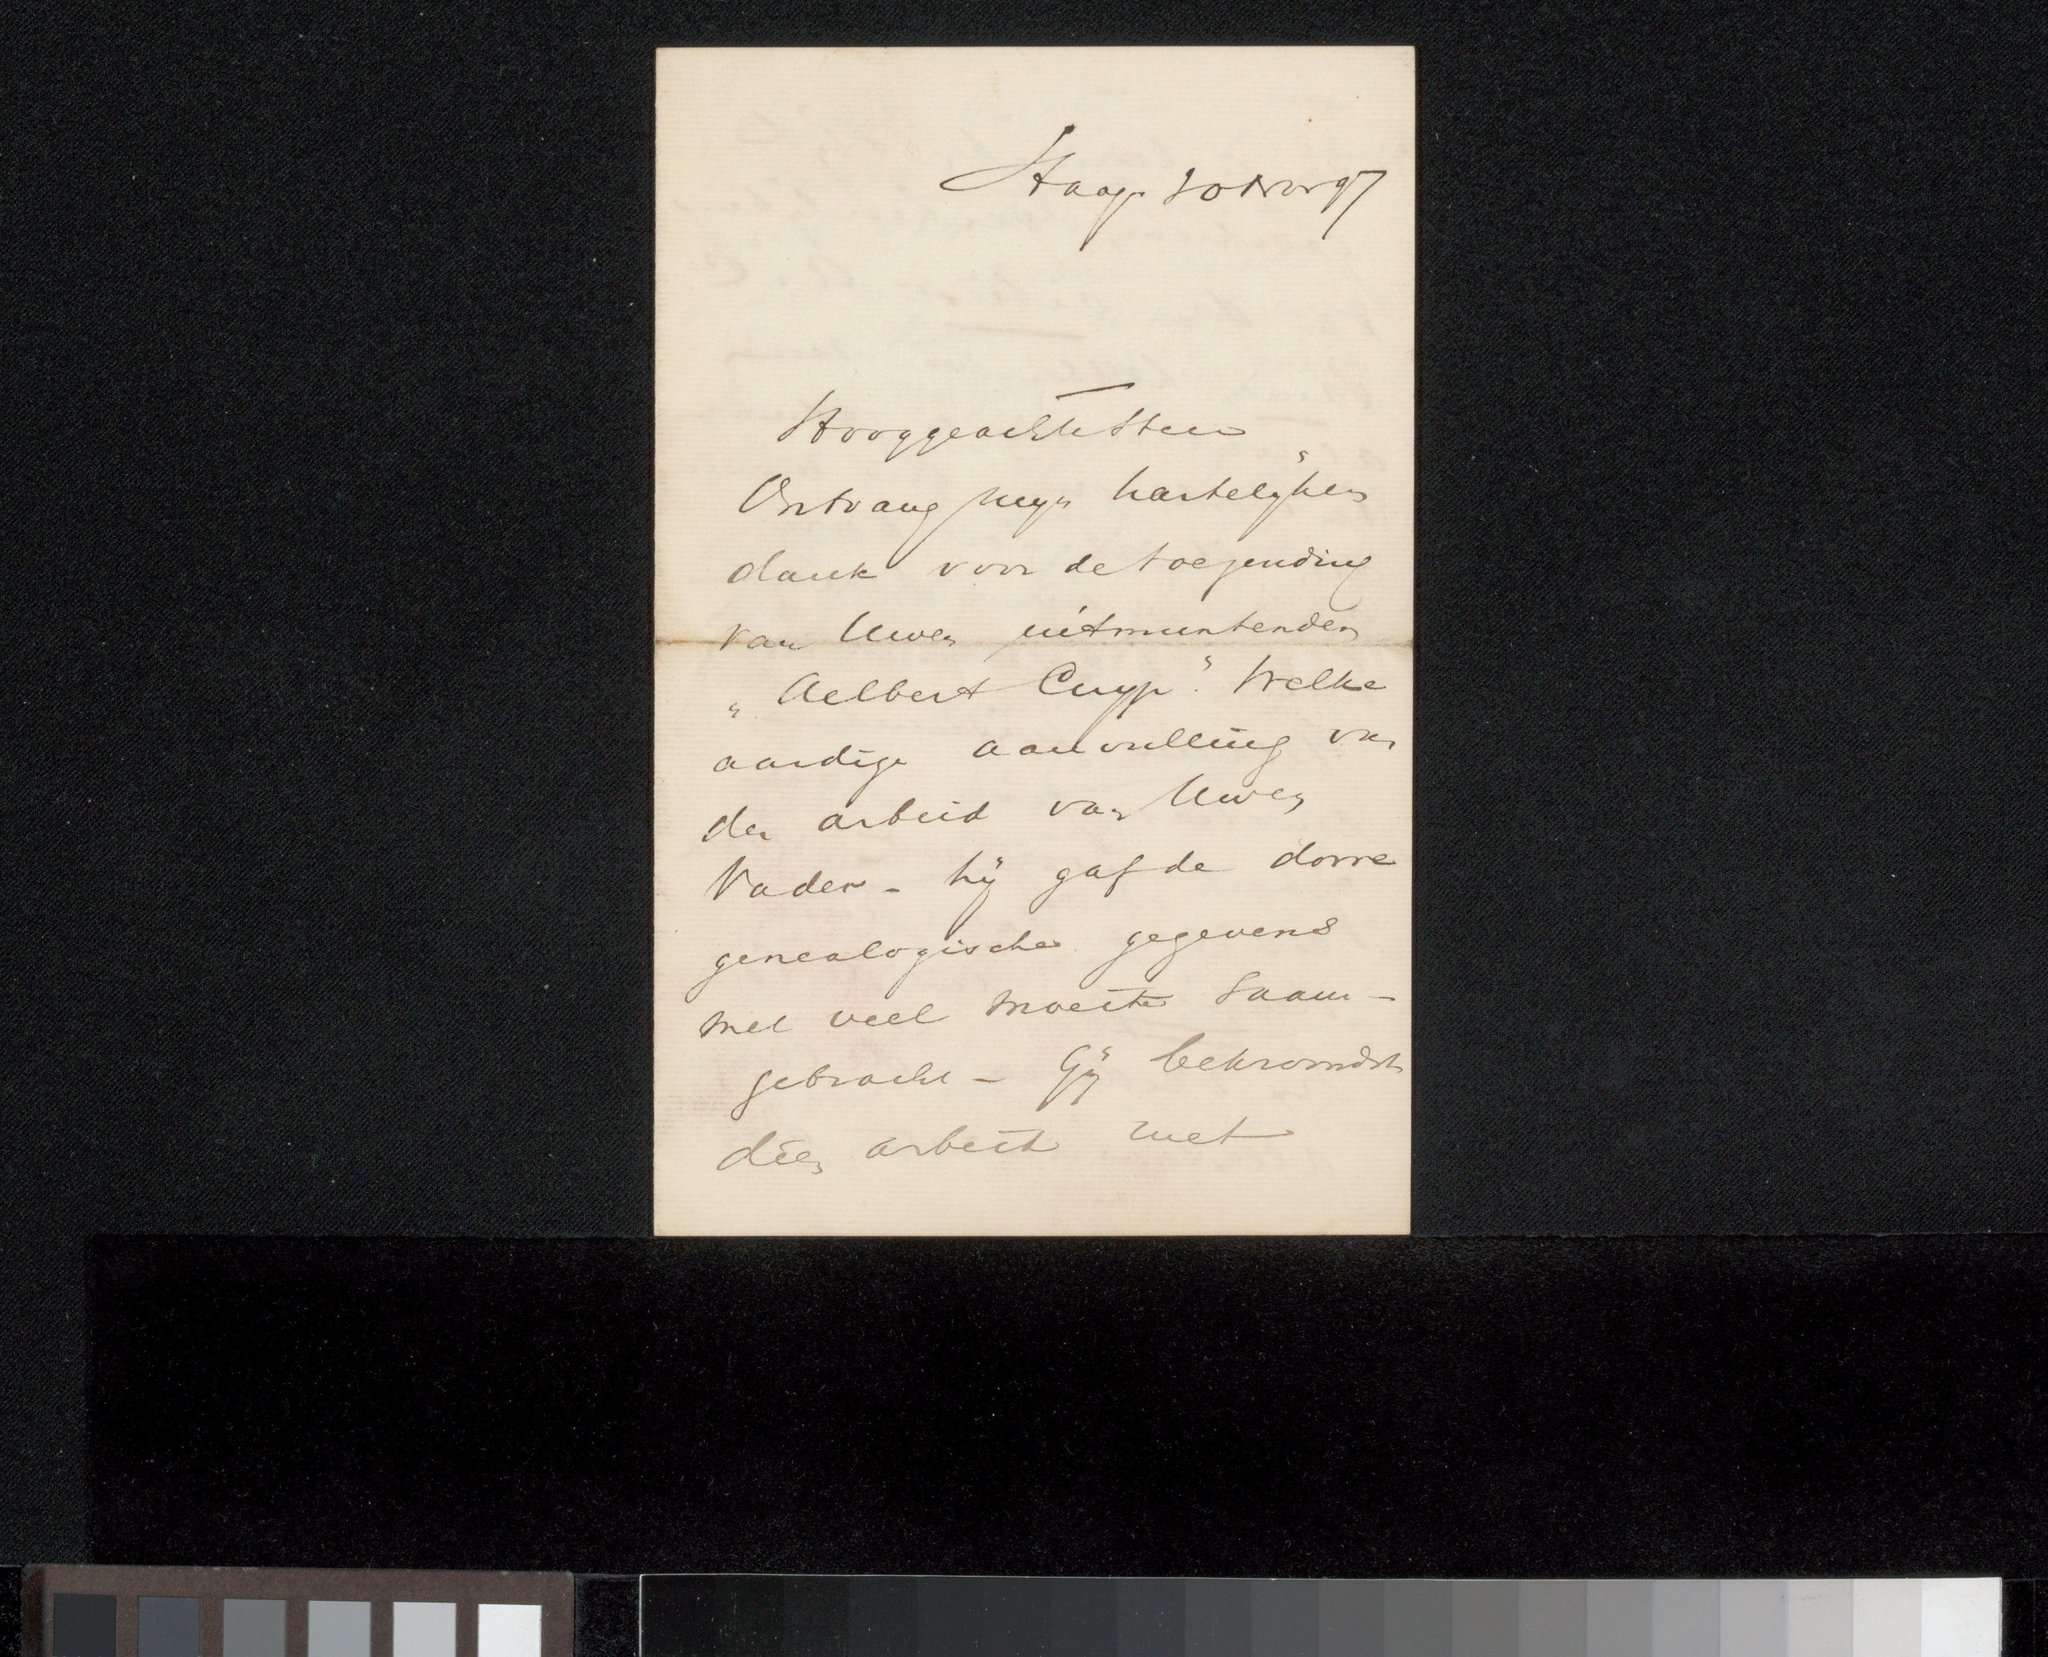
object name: letter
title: Brief aan Jan Veth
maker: abraham bredius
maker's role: kunsthistoricus, museumdirecteur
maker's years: 1855-1946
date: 1897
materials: ink, paper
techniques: pen, writing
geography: the hague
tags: dordrecht, painter, print maker, draughtsman, designer, jan veth, aelbert cuyp, daniël françois scheurleer, printed matter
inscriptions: collector's mark: ‘RPK’